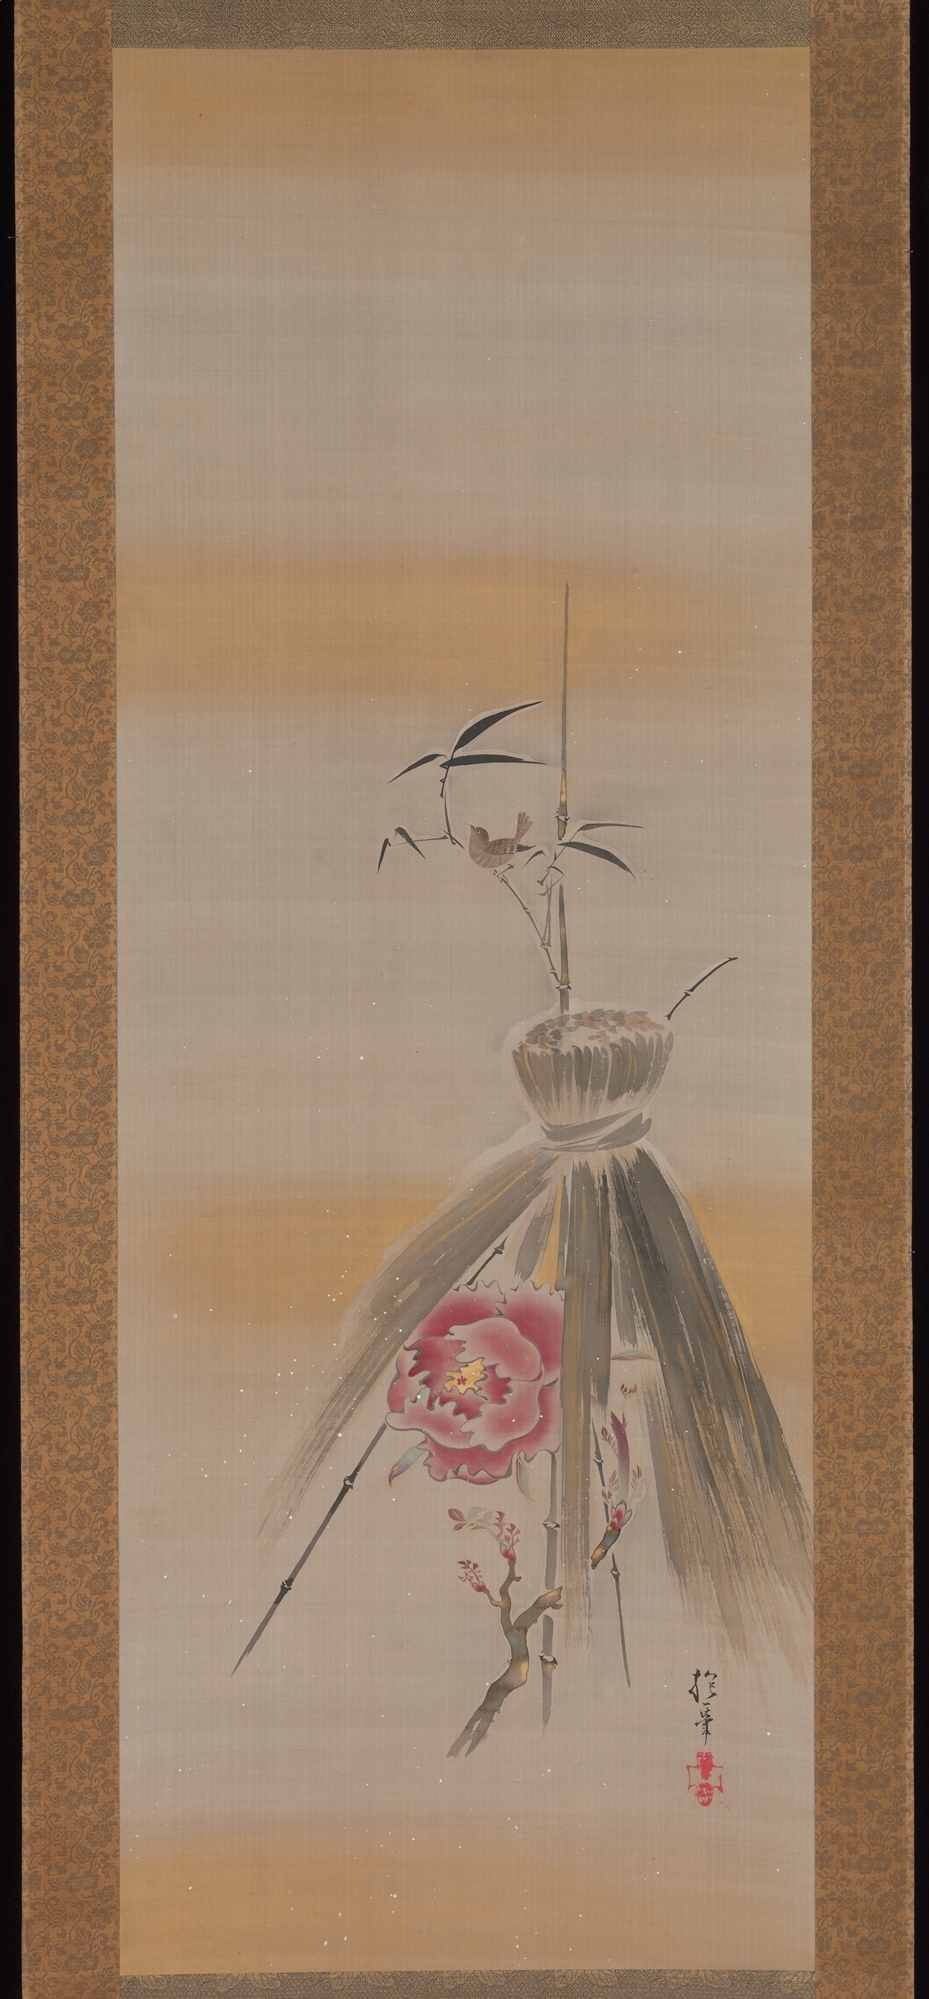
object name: hanging scroll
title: Peony Sheltered by Rice Straw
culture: japanese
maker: sakai hōitsu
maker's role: artist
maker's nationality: japanese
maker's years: 1761-1828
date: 1761-1828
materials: ink, silk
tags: peonies